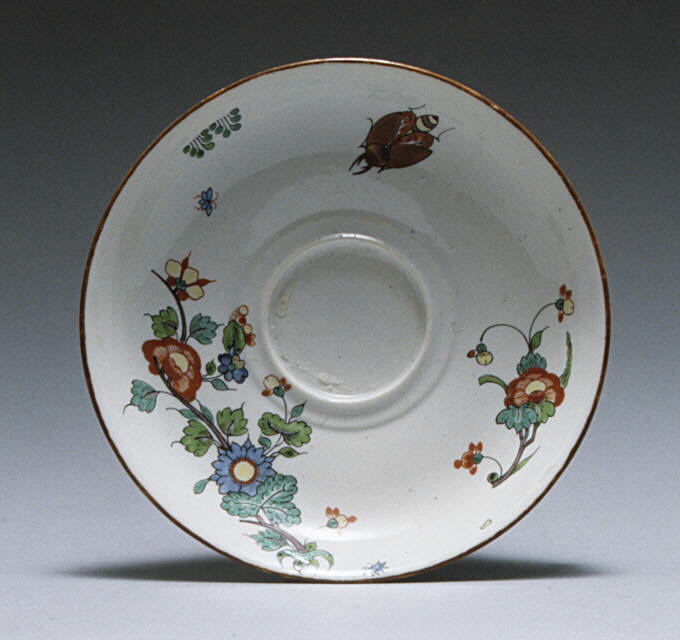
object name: saucer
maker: chantilly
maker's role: factory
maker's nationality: french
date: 1735-1740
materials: soft paste porcelain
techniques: glazing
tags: insects,flowers